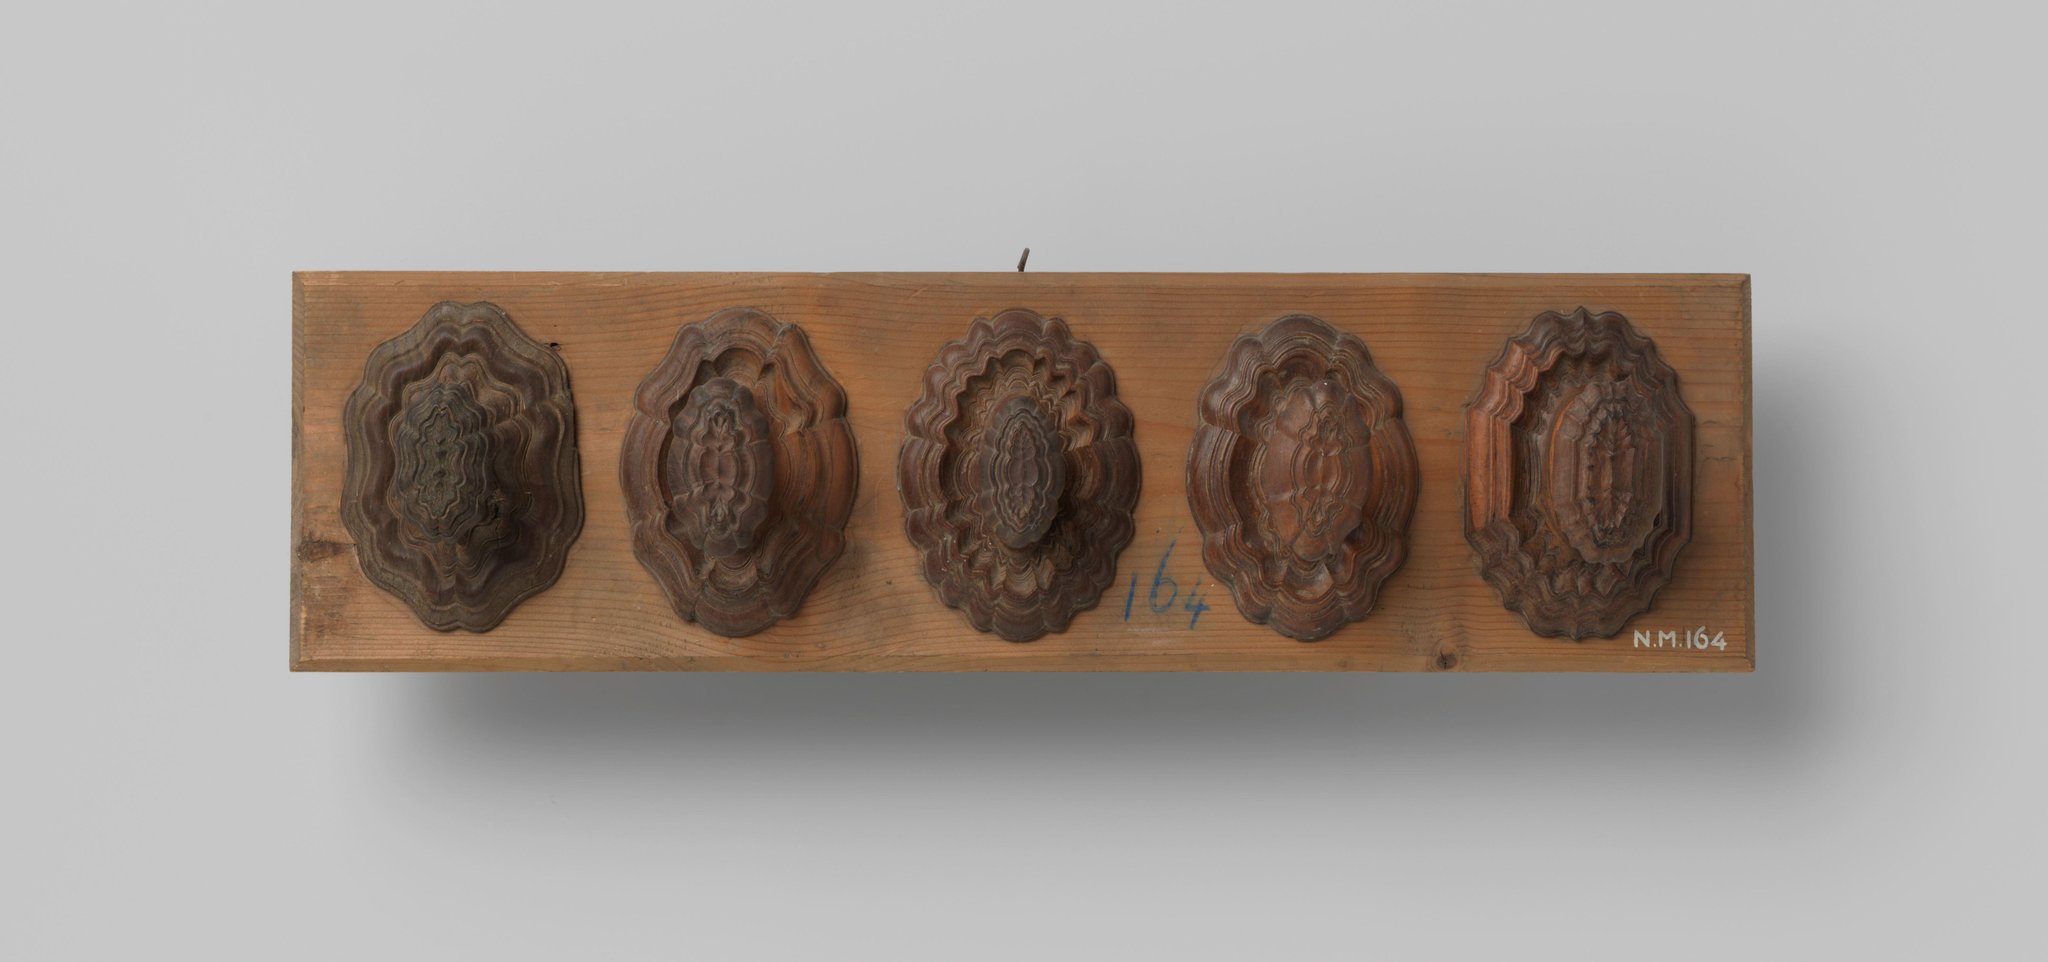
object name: bar handle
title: Deurkruk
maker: Anonymous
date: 1700-1800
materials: wood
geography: netherlands